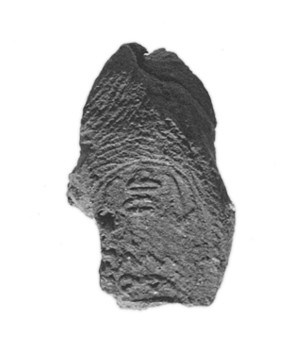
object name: sealing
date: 2030-1640 BCE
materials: clay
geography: egypt